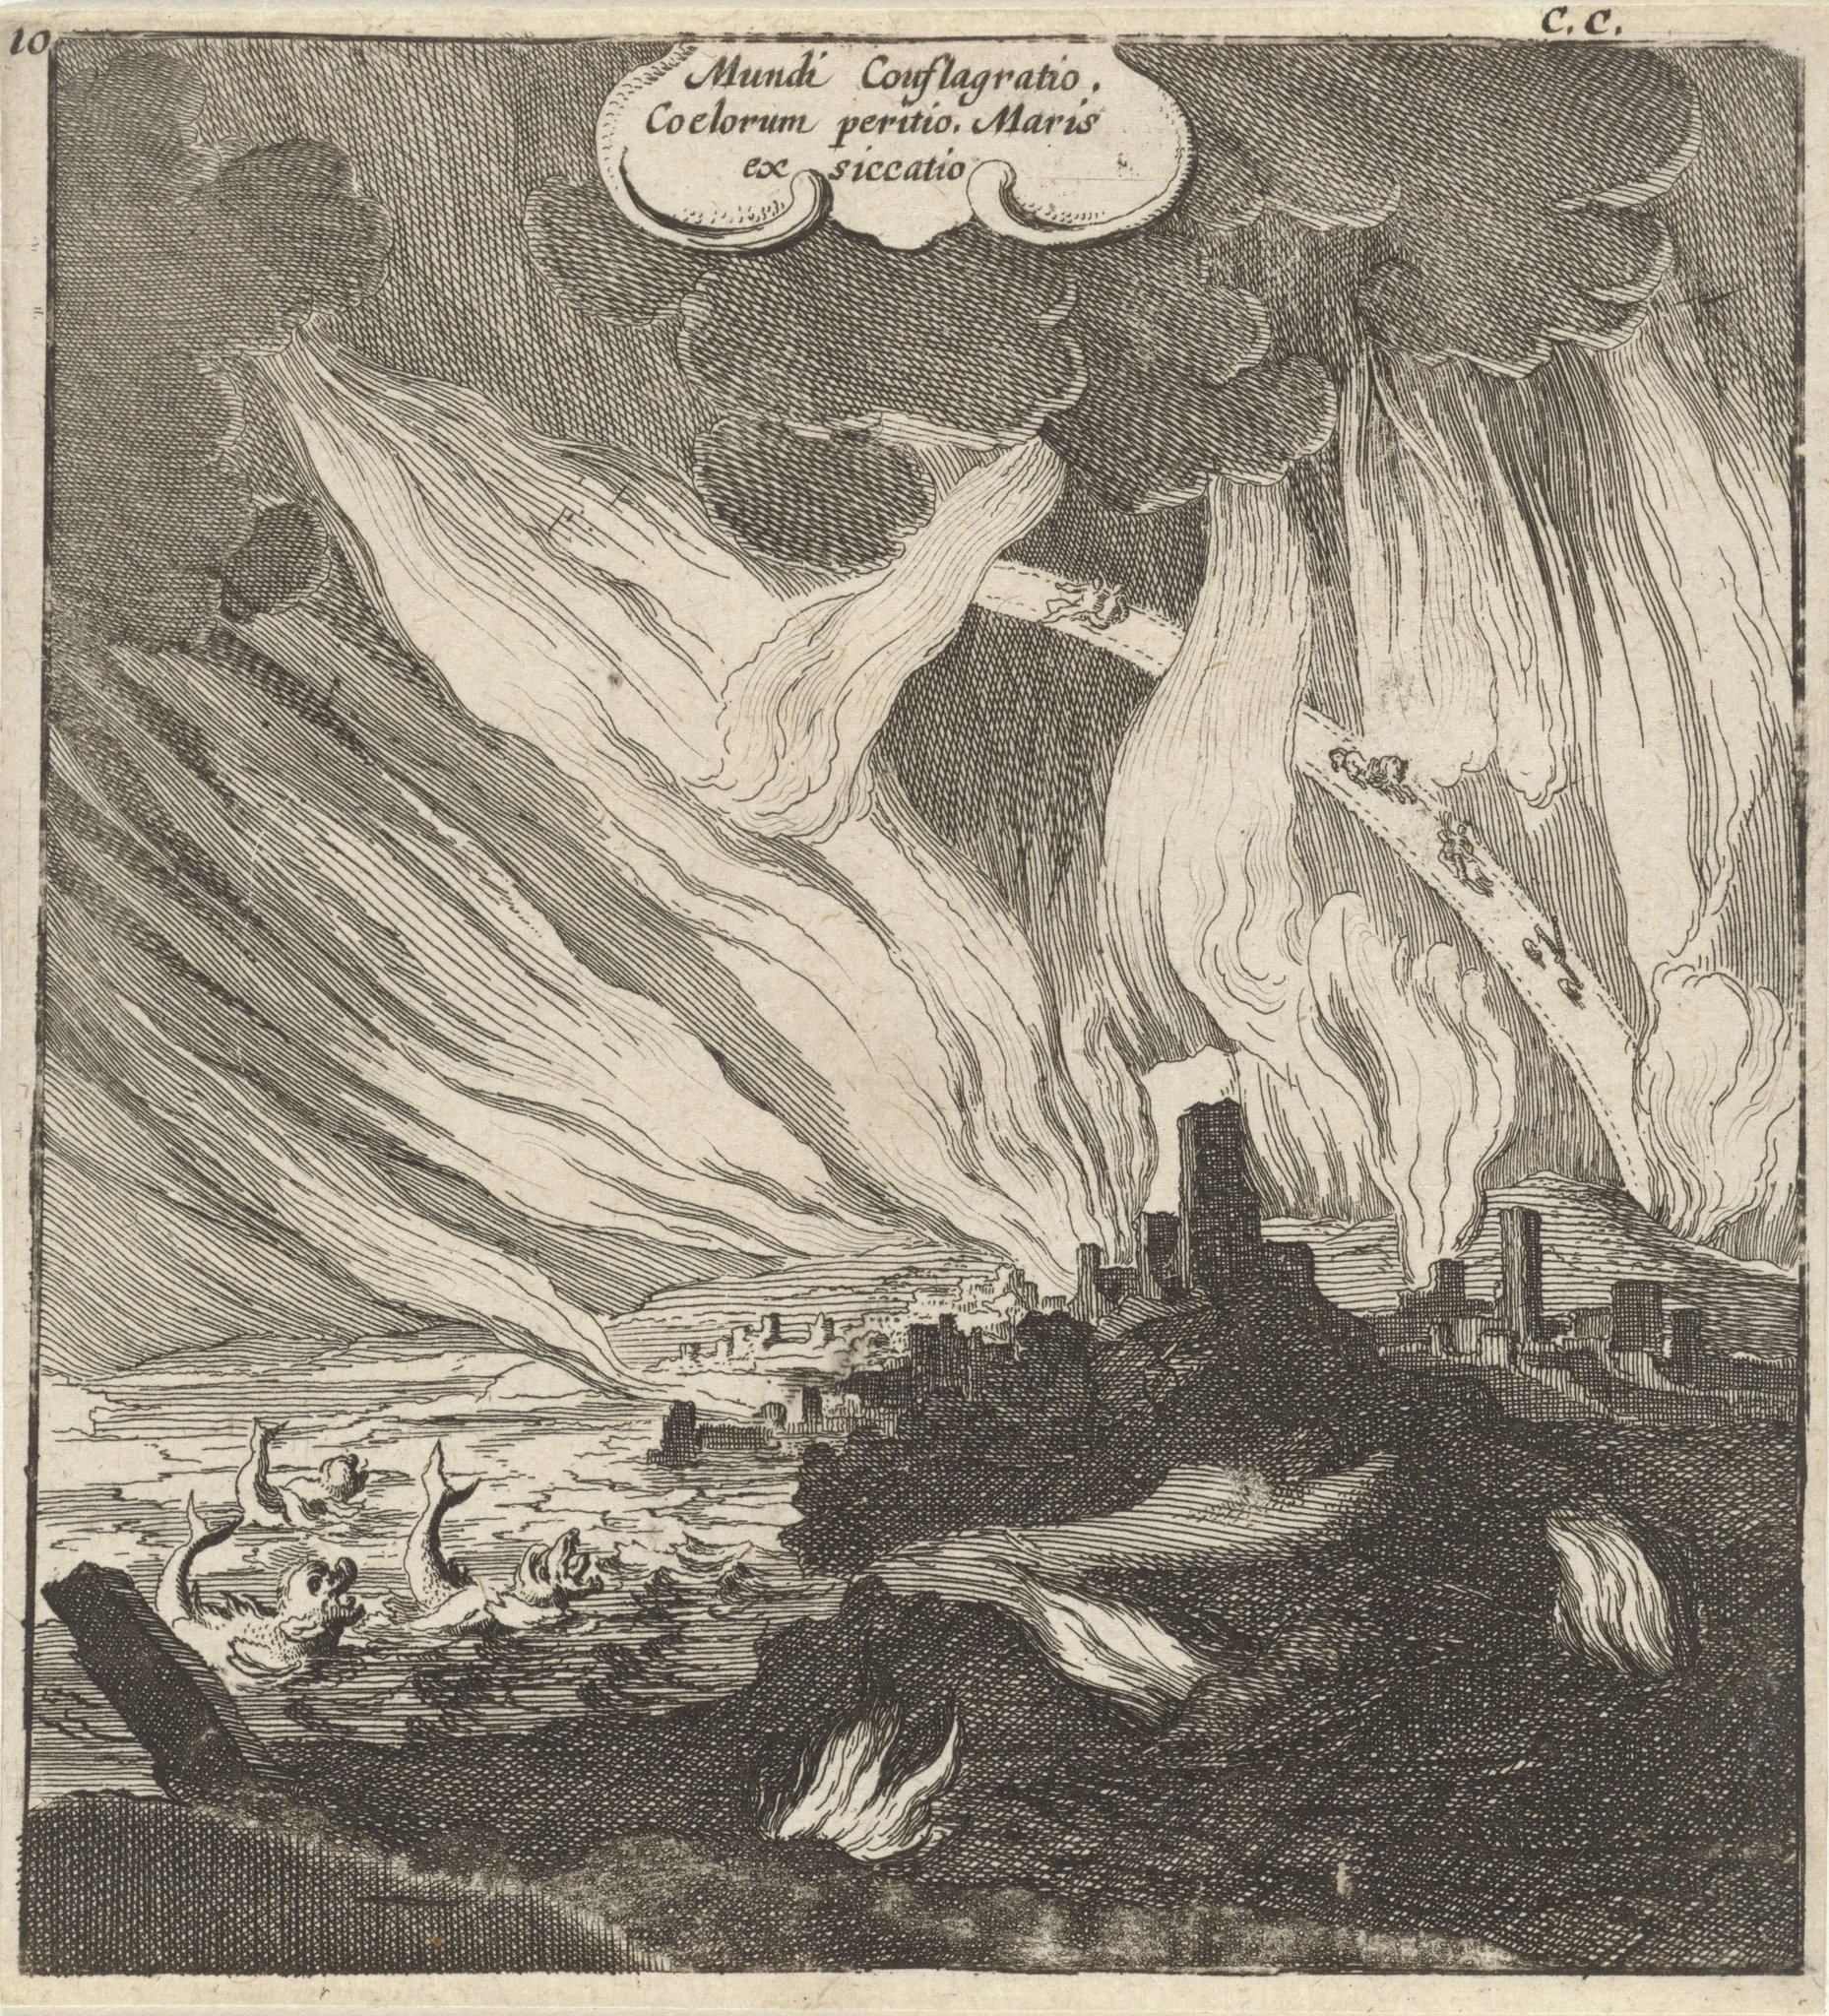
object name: book illustration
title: Het vergaan van de aarde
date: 1625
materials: paper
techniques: etching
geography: haarlem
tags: last judgement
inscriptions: collector's mark: Lugt 2228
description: Illustratie in: Peil, Johann. Tabula processum seu ordinem ultimi divini et criminalis judicii exhibens. Kleef: Gerhardus Verstegen, 1625, p. 72.